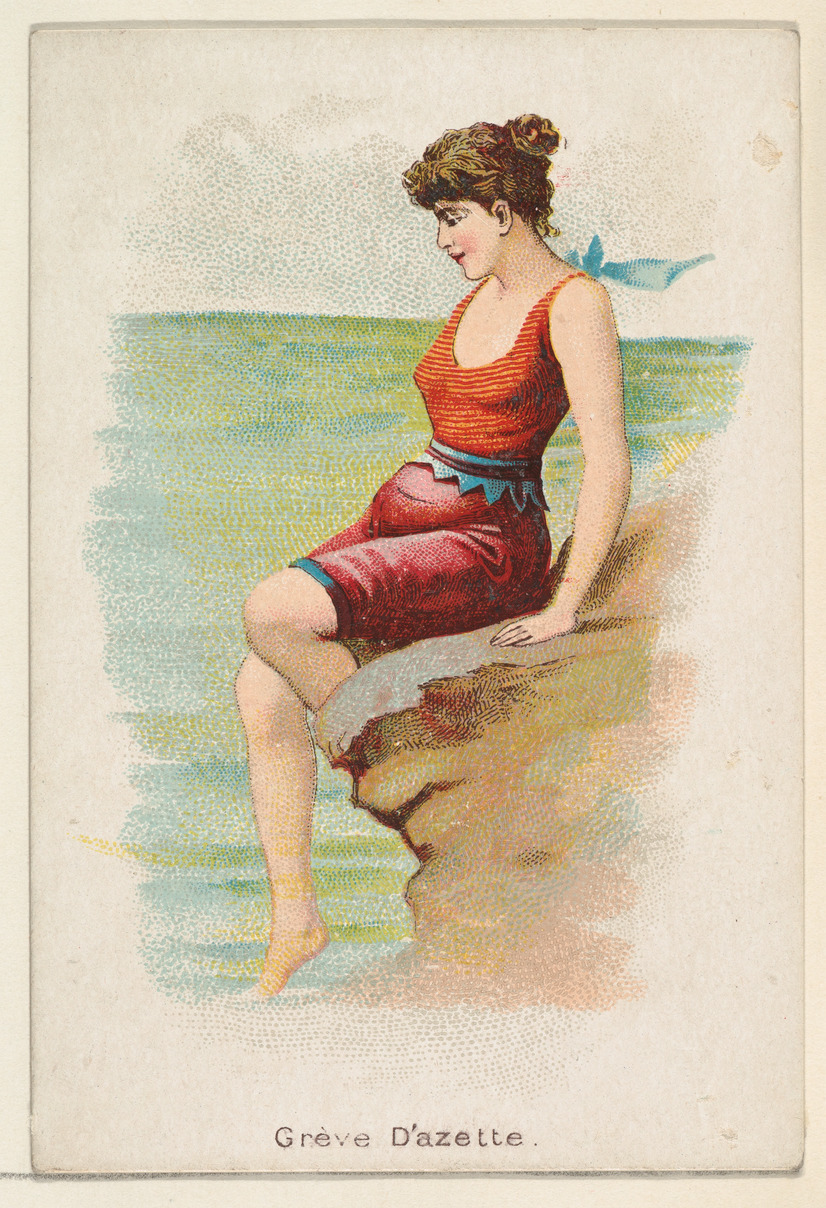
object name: print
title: Grève d' Azette, from the Beautiful Bathers series (N192) issued by Wm. S. Kimball & Co.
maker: william s. kimball & company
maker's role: publisher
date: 1889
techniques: color lithograph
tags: profiles,women